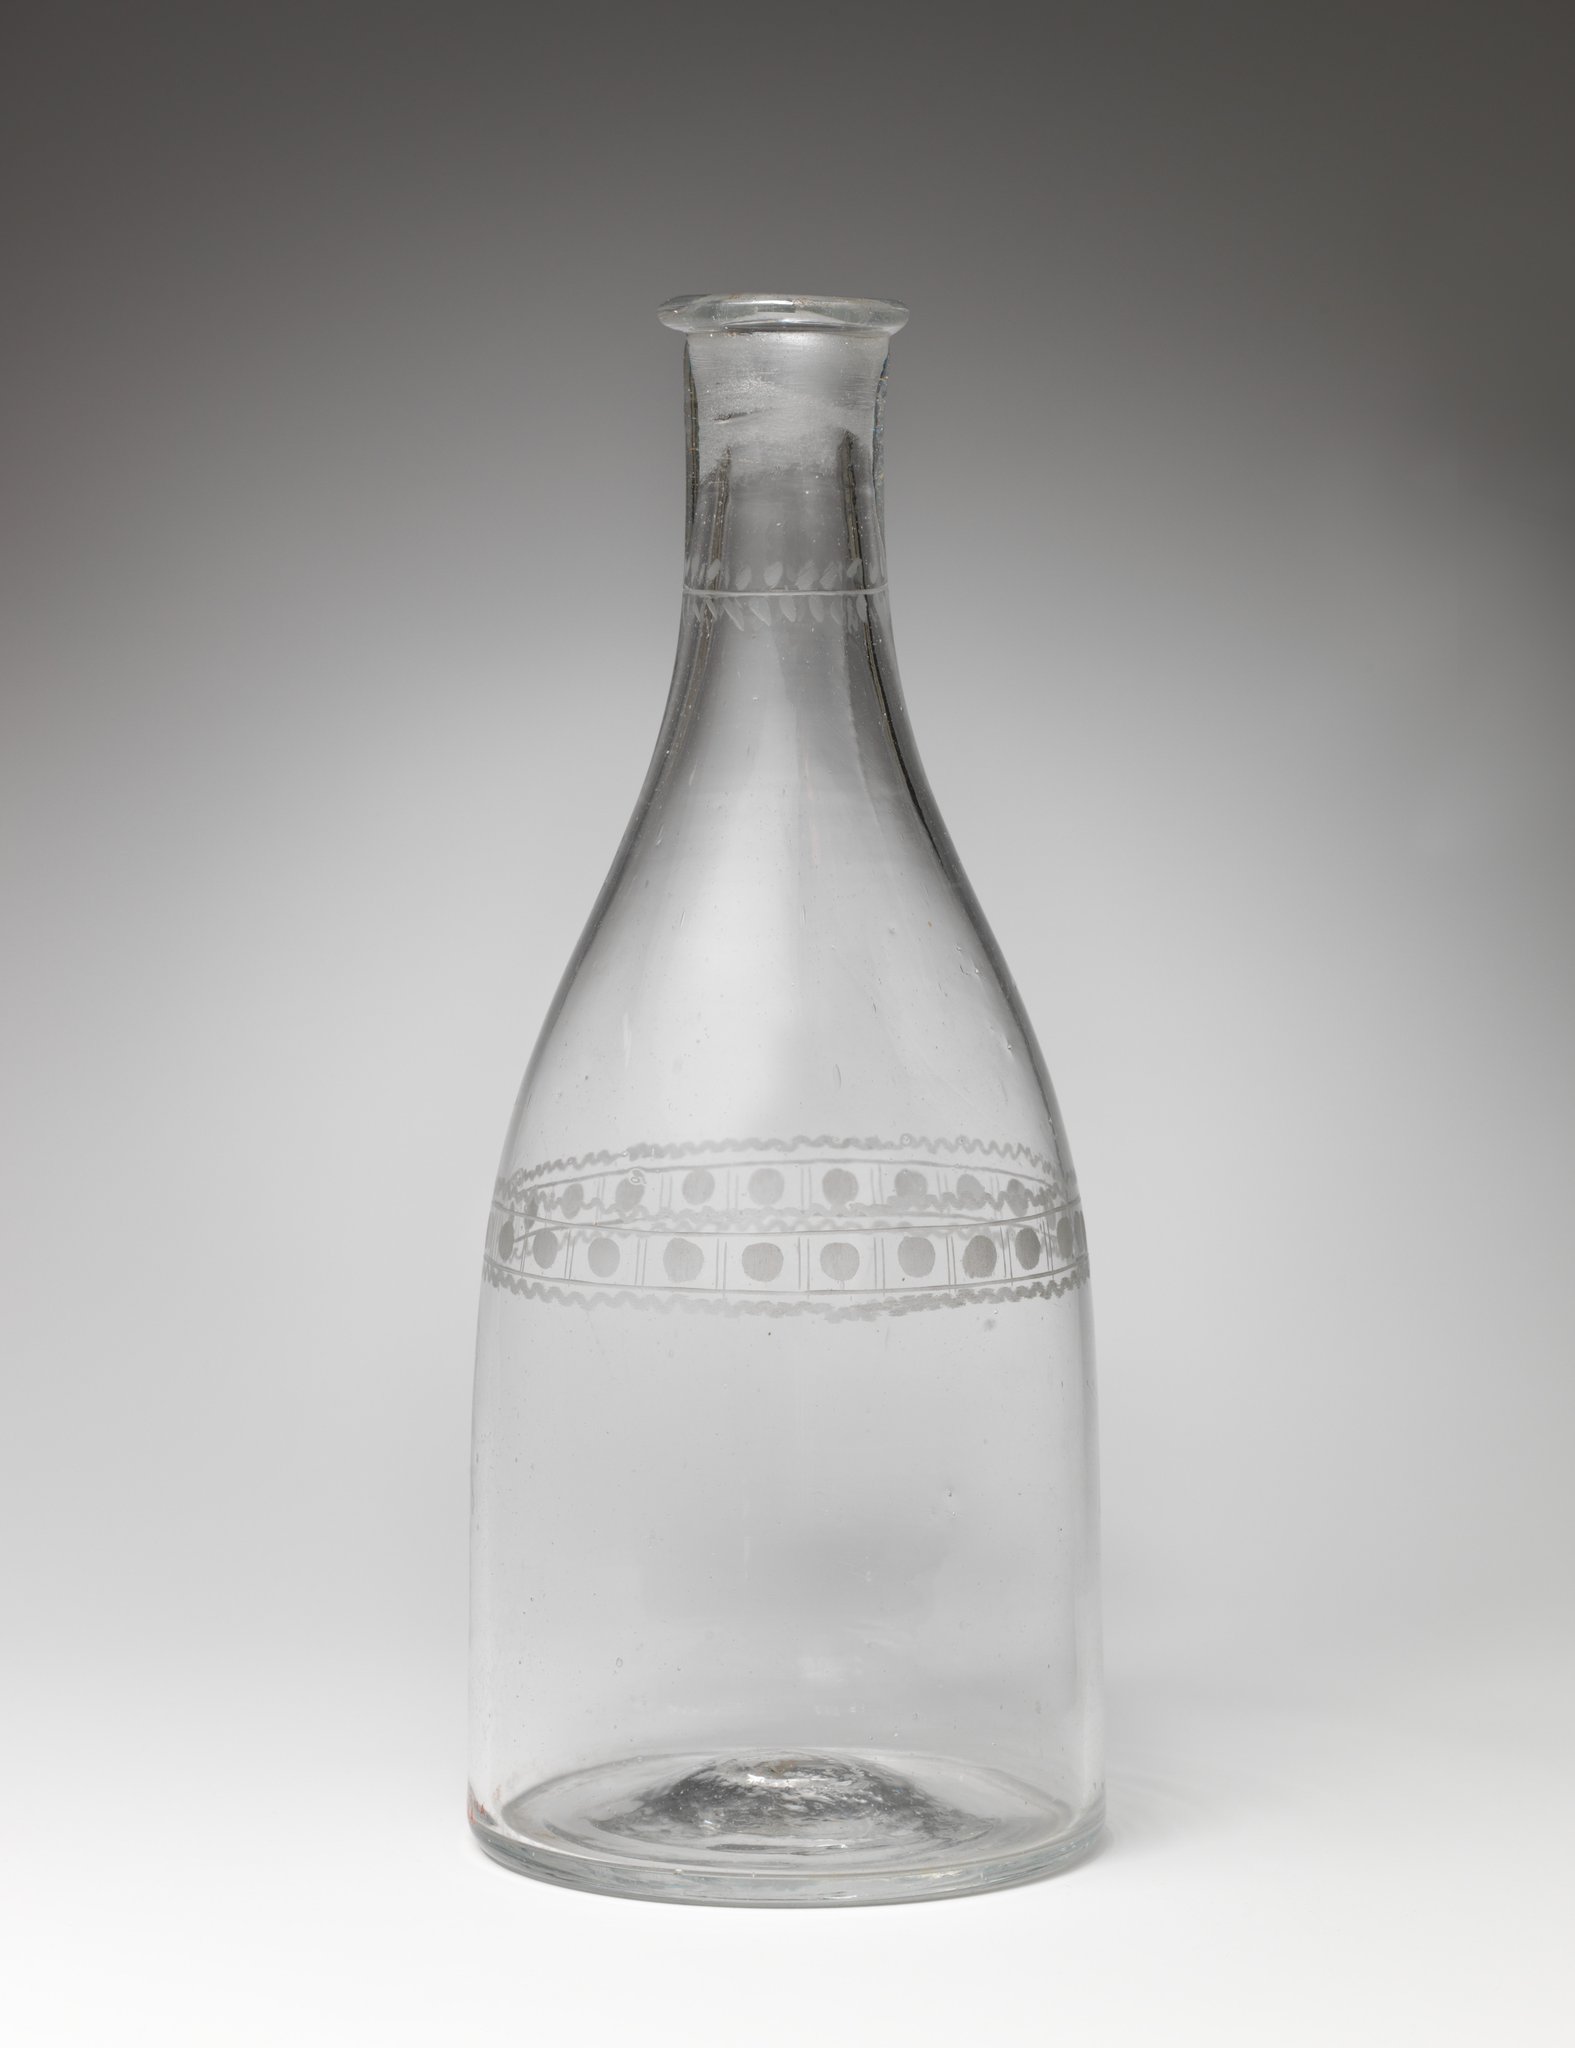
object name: decanter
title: Decanter (one of a pair)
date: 1701-1800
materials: glass